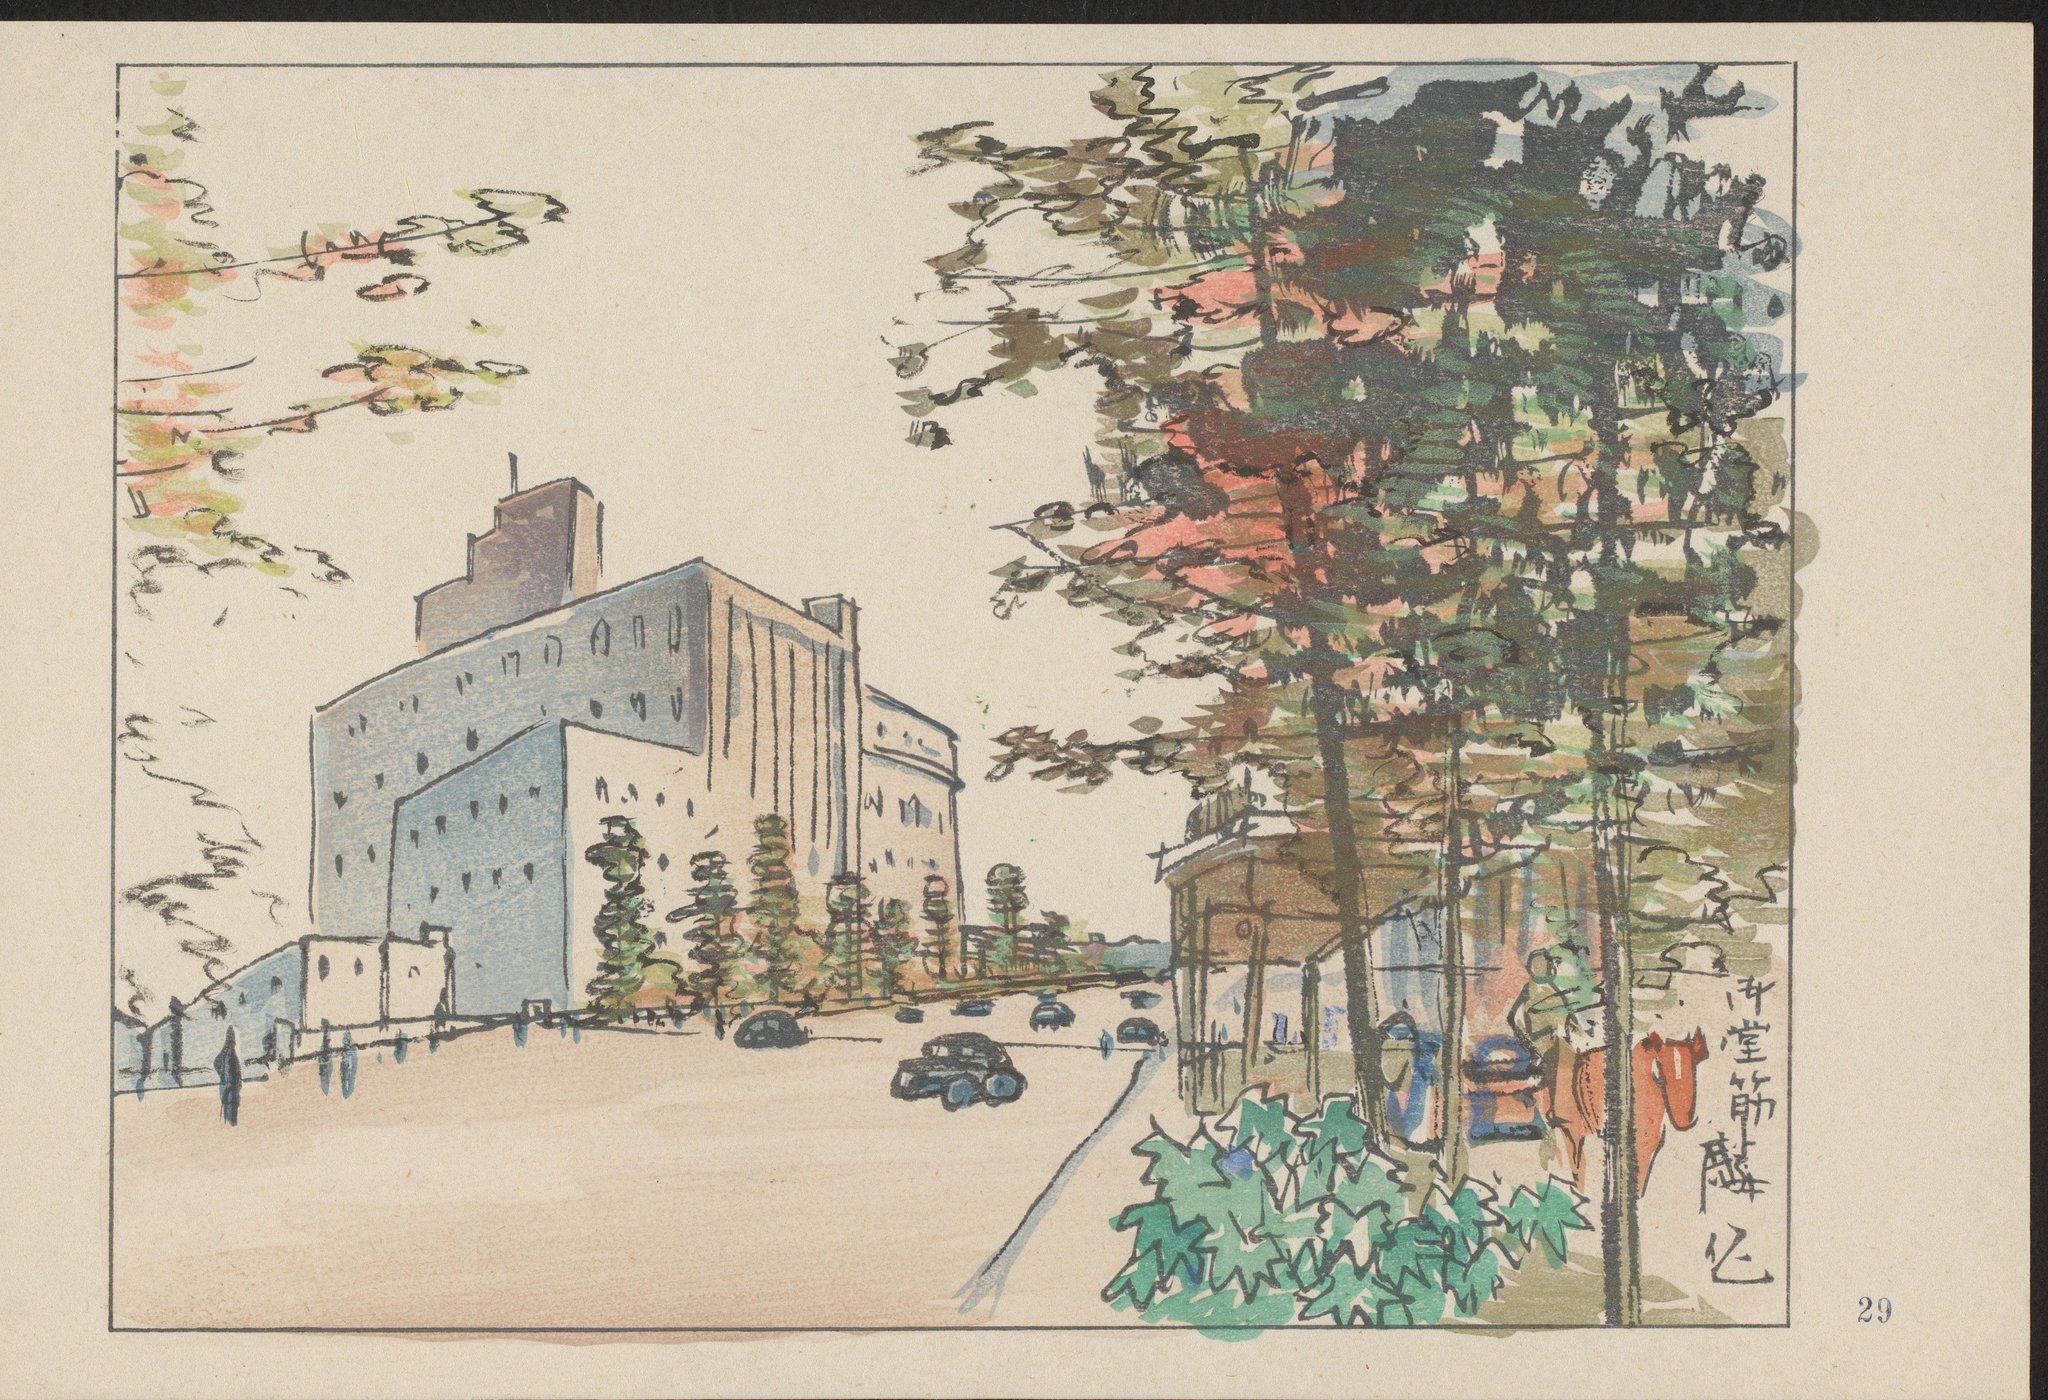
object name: print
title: Midôsuji, a business center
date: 1947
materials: paper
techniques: woodcut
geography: japan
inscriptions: date